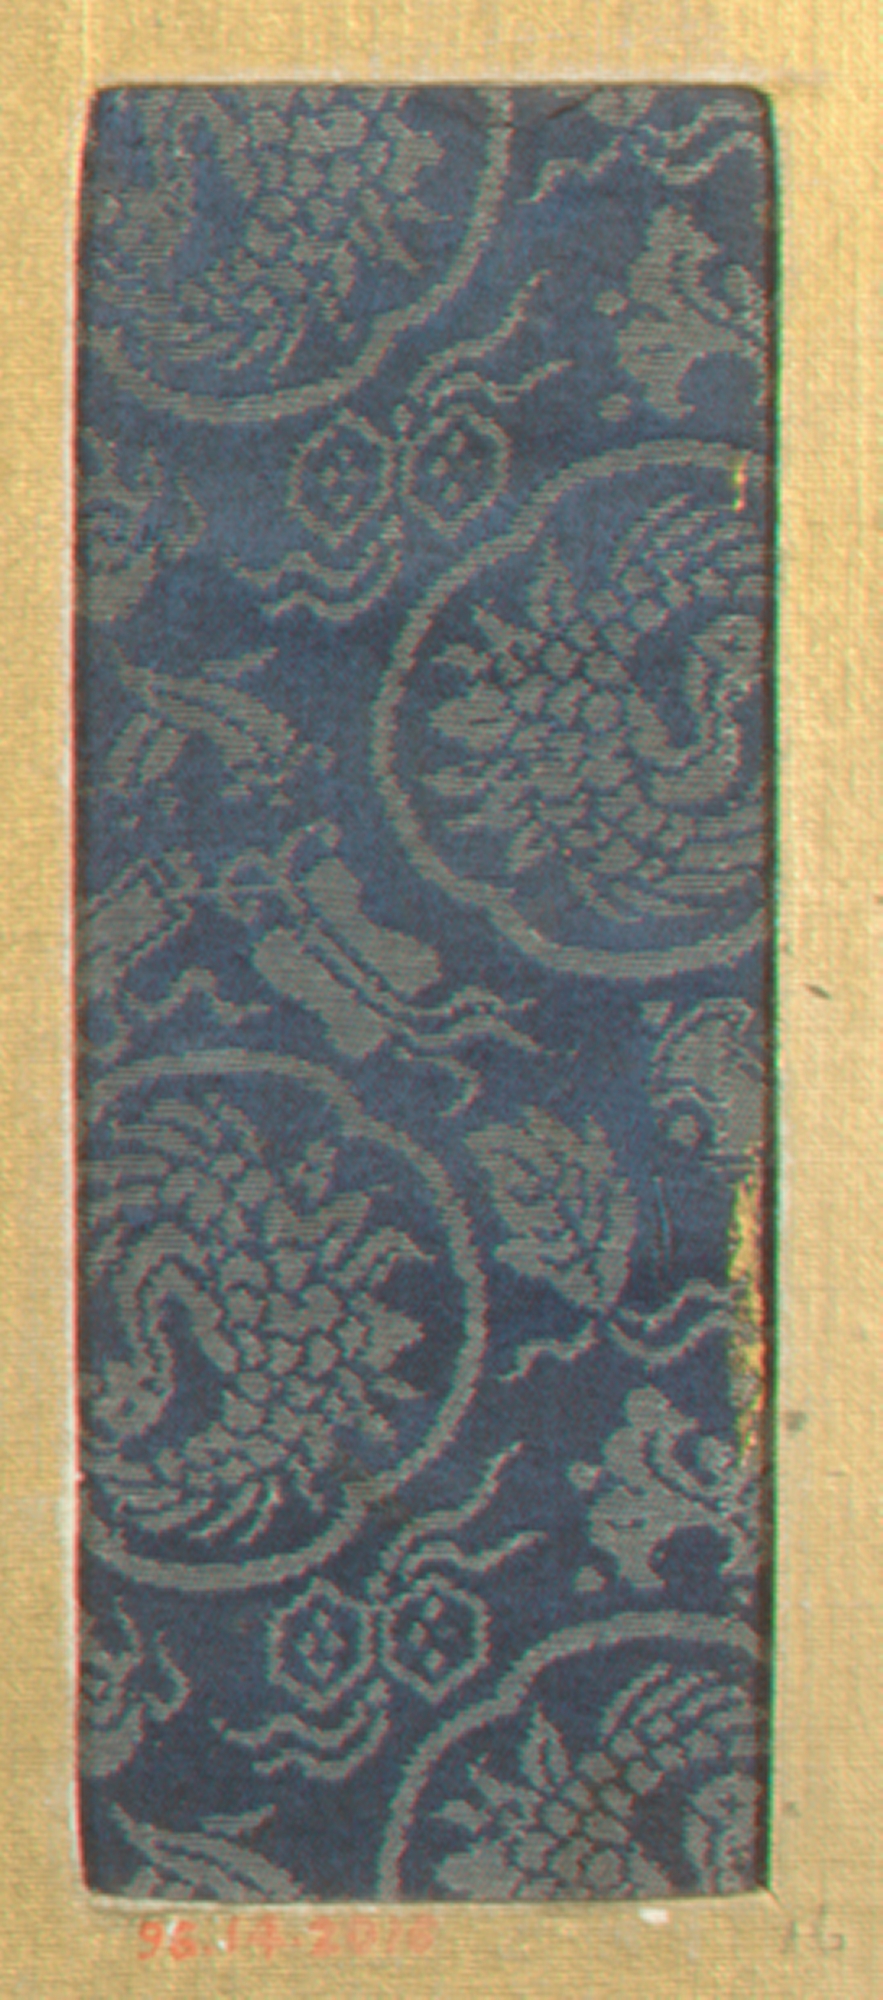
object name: piece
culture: japanese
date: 1701-1900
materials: silk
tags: birds